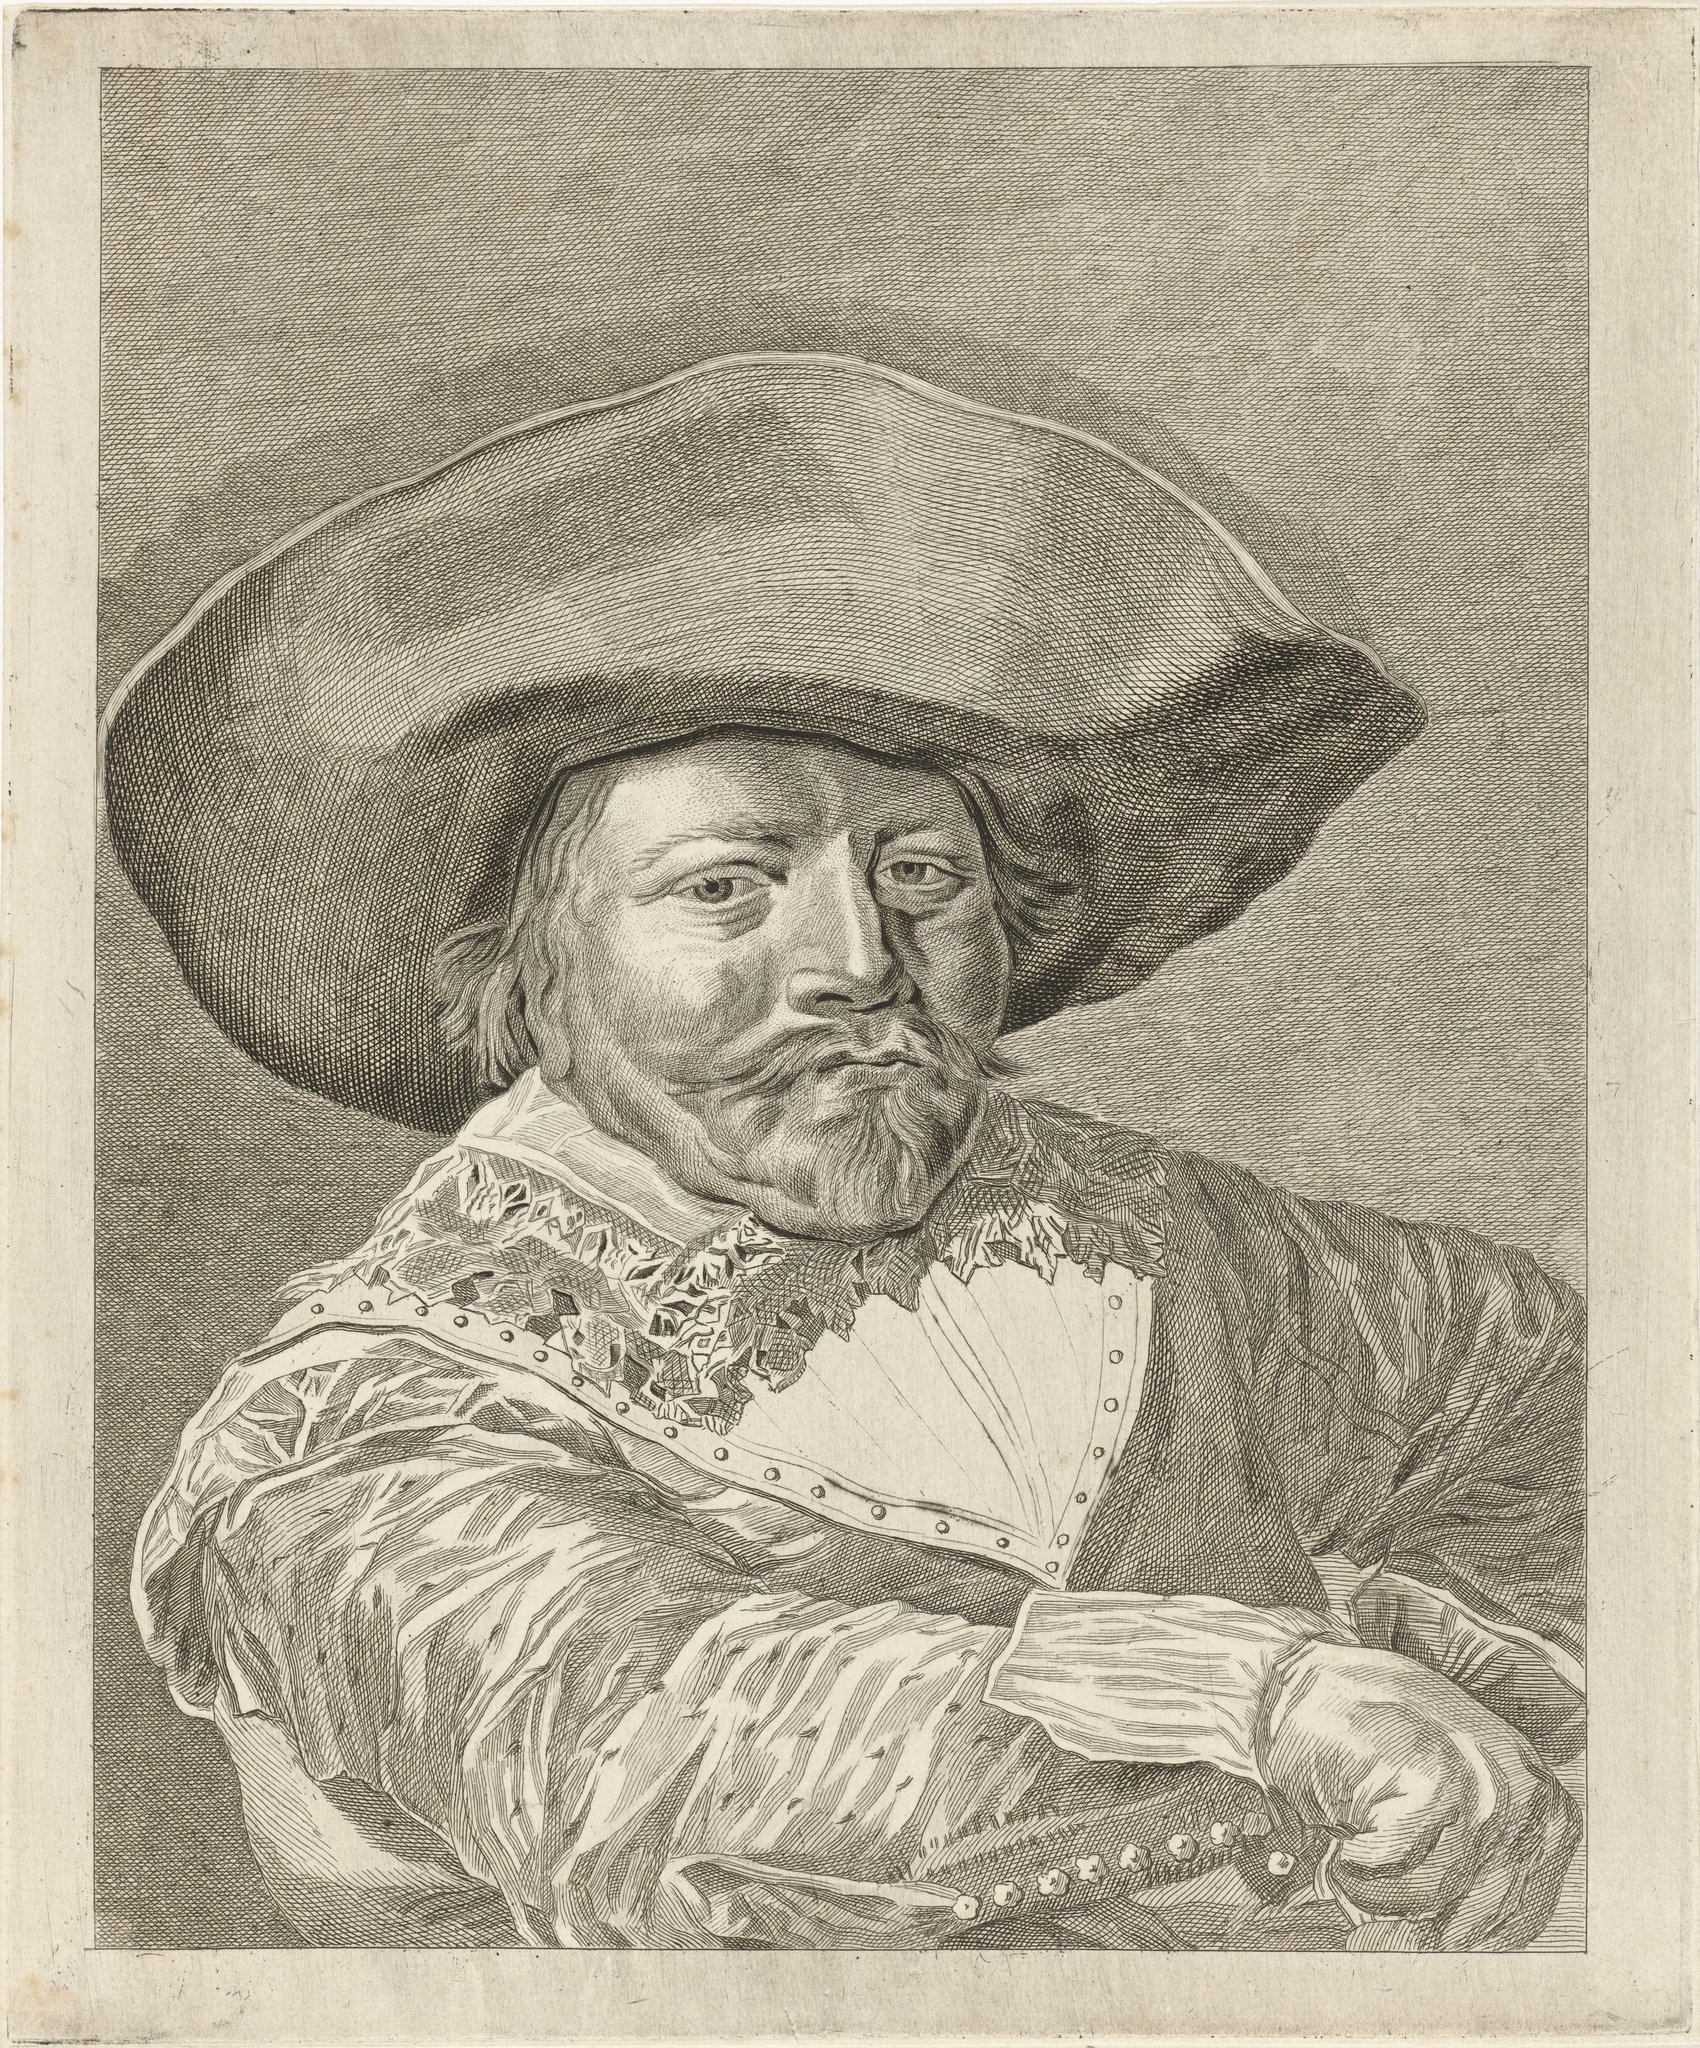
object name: print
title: Portret van een man in 17e-eeuws kostuum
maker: pieter de mare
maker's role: print maker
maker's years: 1758-1796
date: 1768-1796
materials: paper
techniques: engraving, etching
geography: leiden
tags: head-gear: hat (+ men's clothes)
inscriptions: collector's mark: Lugt 240